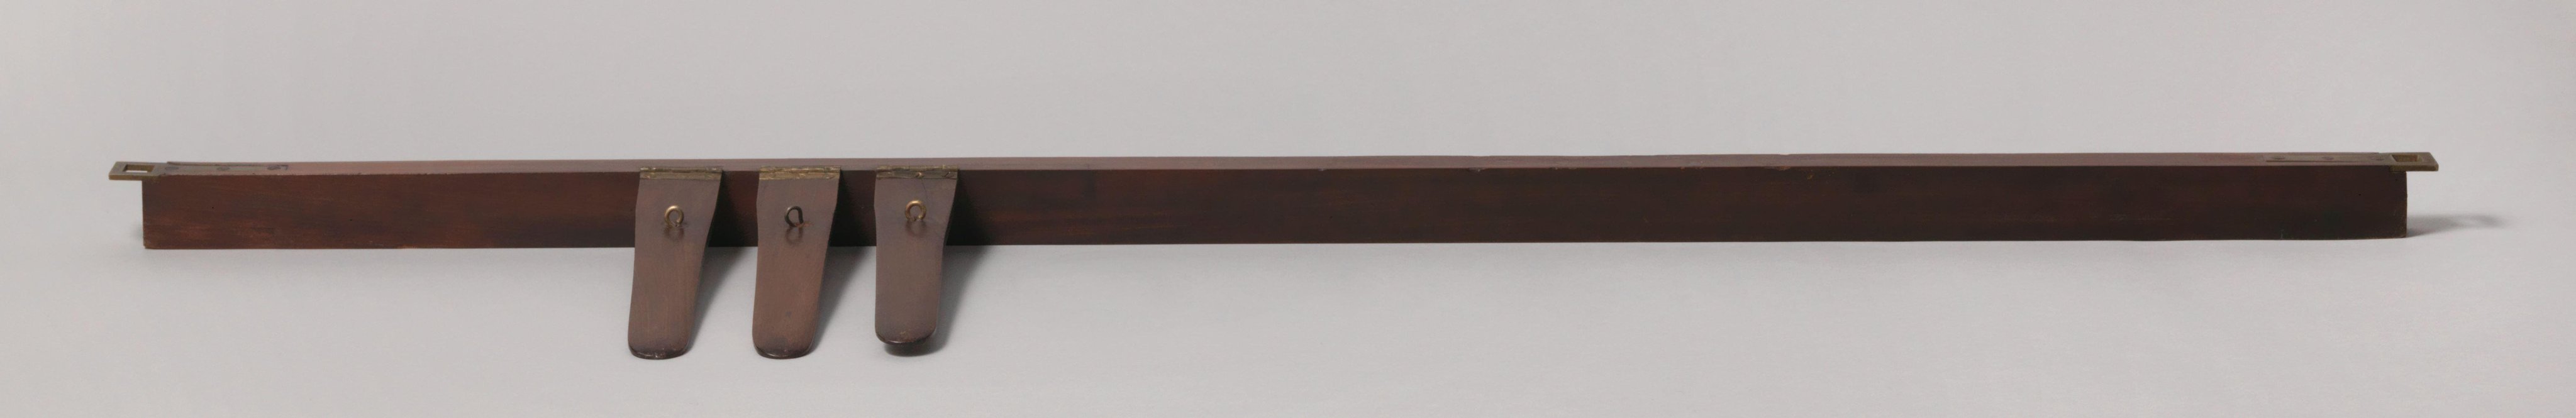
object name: pianoforte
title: Element of piano, P. Fabritius, The Hague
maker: pieter leonhardus fabritius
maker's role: musical instrument maker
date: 1808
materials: copper, wood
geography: the hague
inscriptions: date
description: Lat met pedalen hoort bij de piano BK-NM-8192